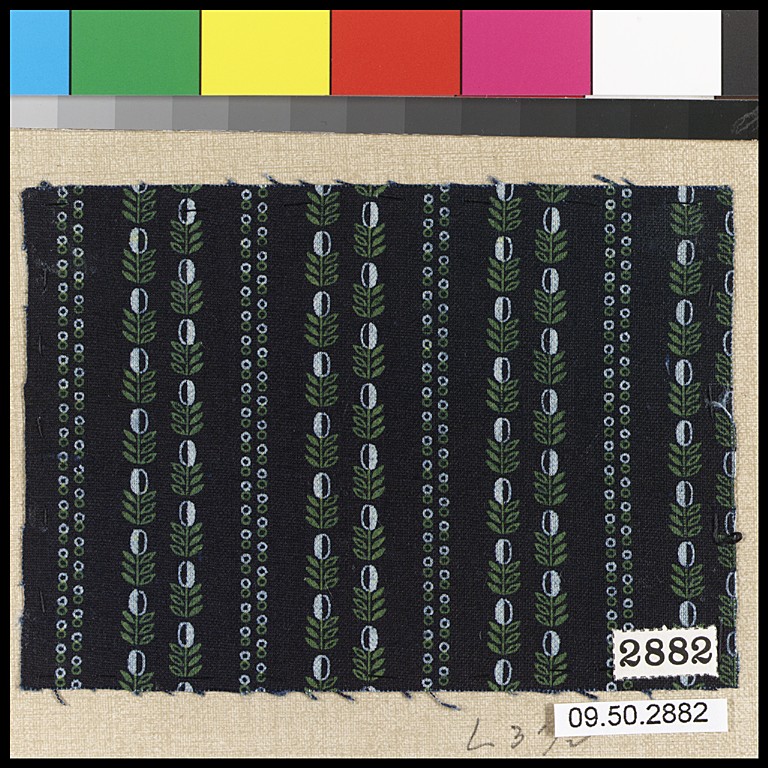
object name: piece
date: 1801-1900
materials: cotton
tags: leaves